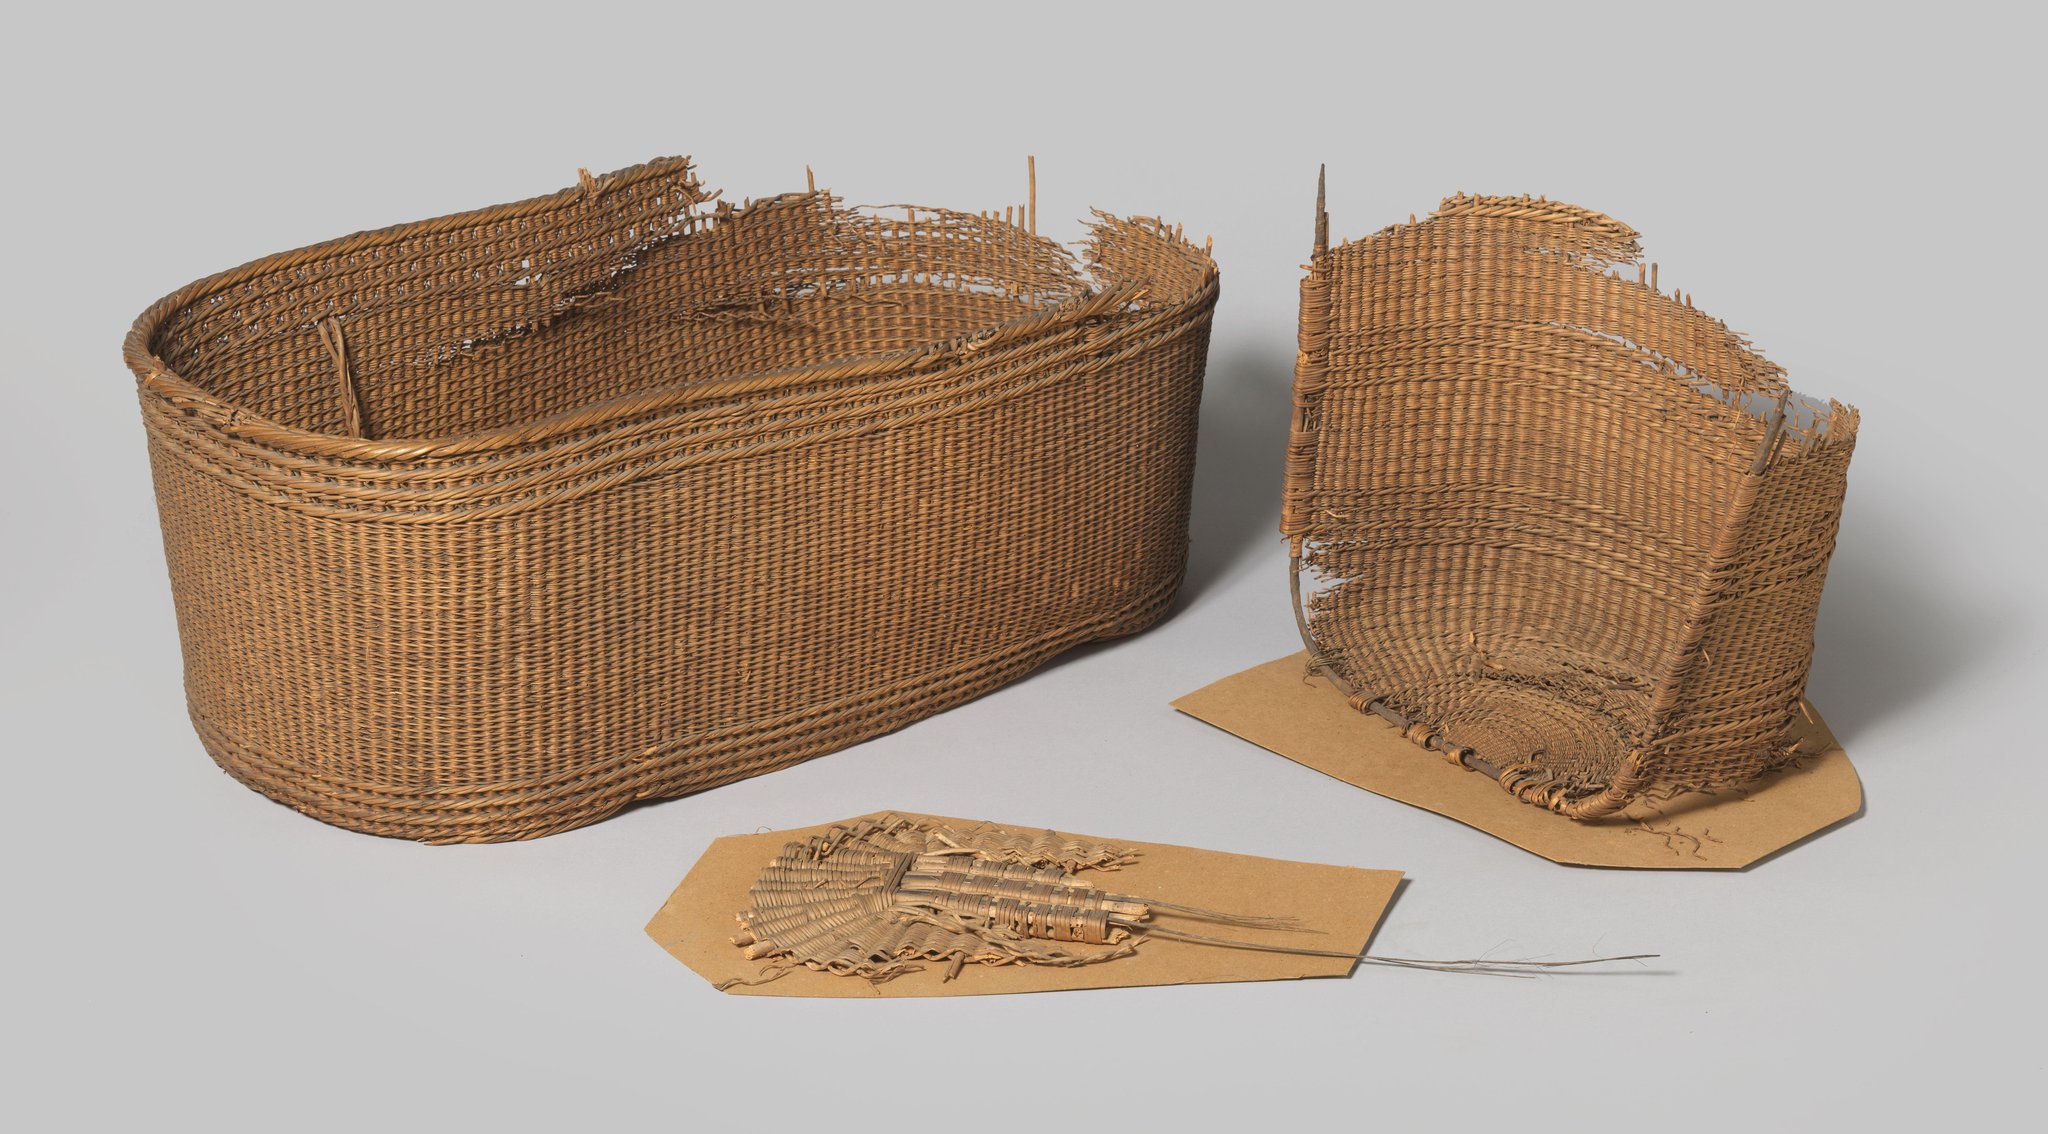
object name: furniture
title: Mandwieg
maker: Anonymous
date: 1685-1700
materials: reed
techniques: riet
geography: northern netherlands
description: Mandewieg. De wieg is gedekt met een blauw damasten wiegekleed, hangend aan een voorgezette lambrekijn. Het dek is versierd met band- en koordoplegsels en franje, in wit. De wieg is half vergaan. Opmerking: het wiegenkleed bestaat uit twee delen, beide bevestigd aan het lambrekijn.